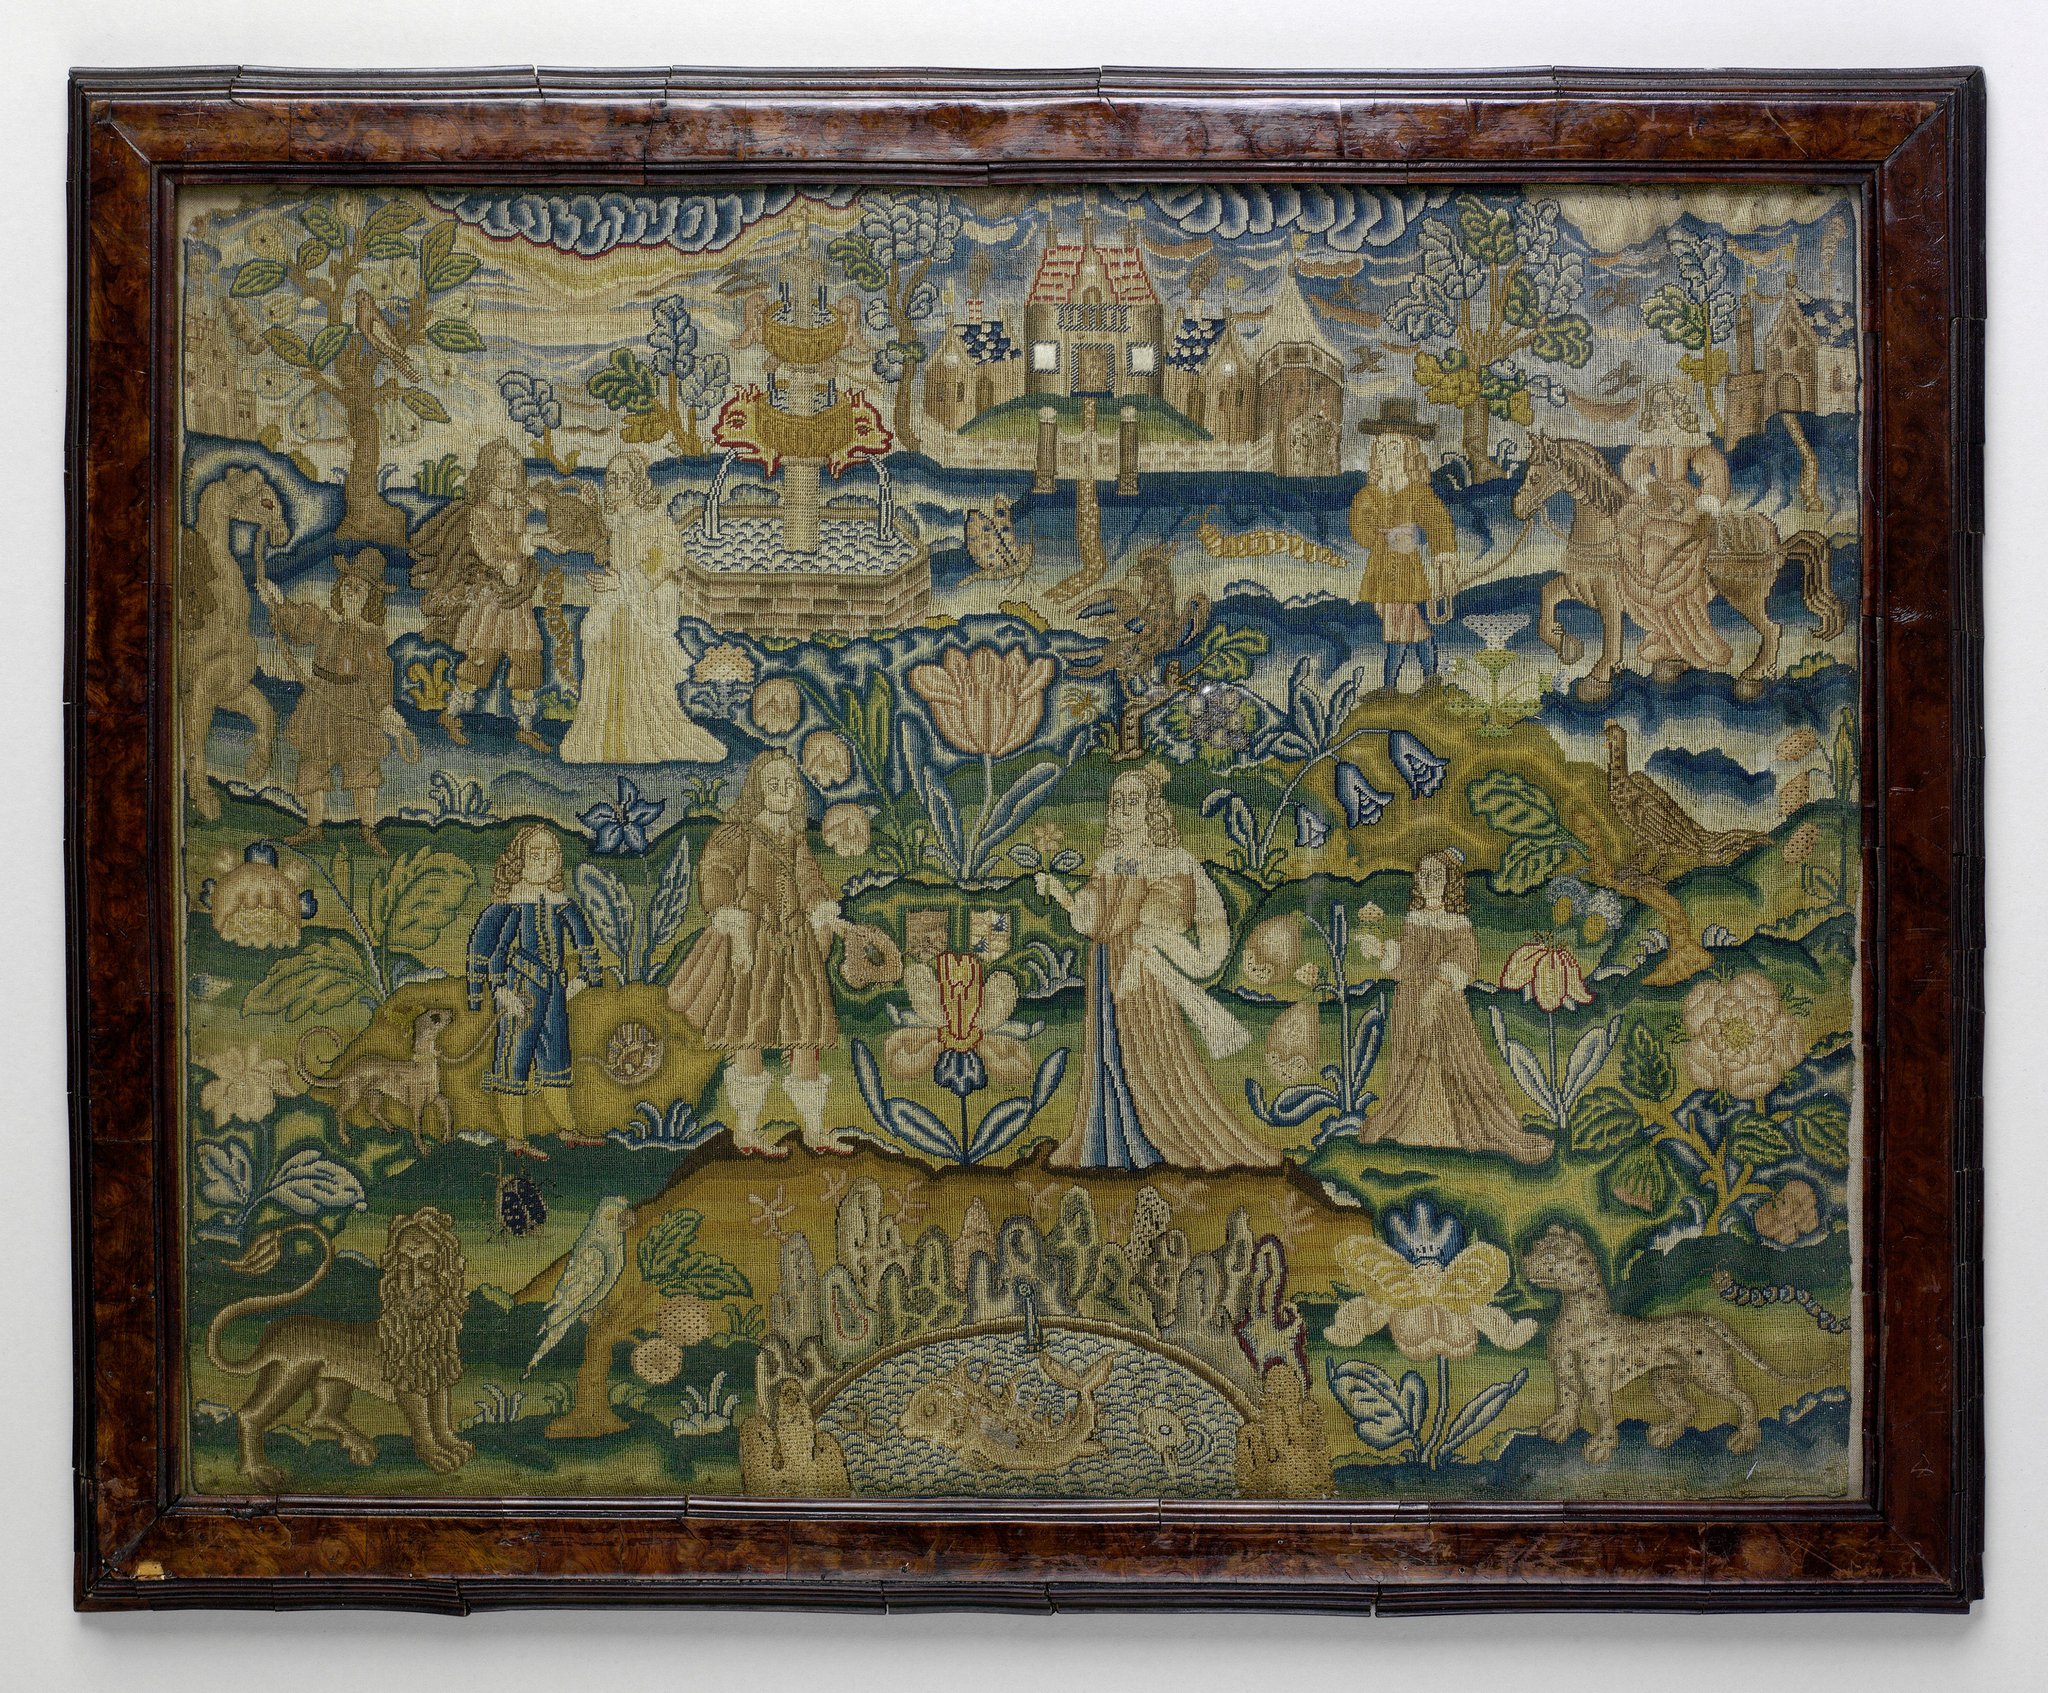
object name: embroidered picture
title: Eliezer and Rebecca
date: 1651-1675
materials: canvas, textile, silk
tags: birds,fountains,men,women,fish,horses,butterflies,lions,flowers